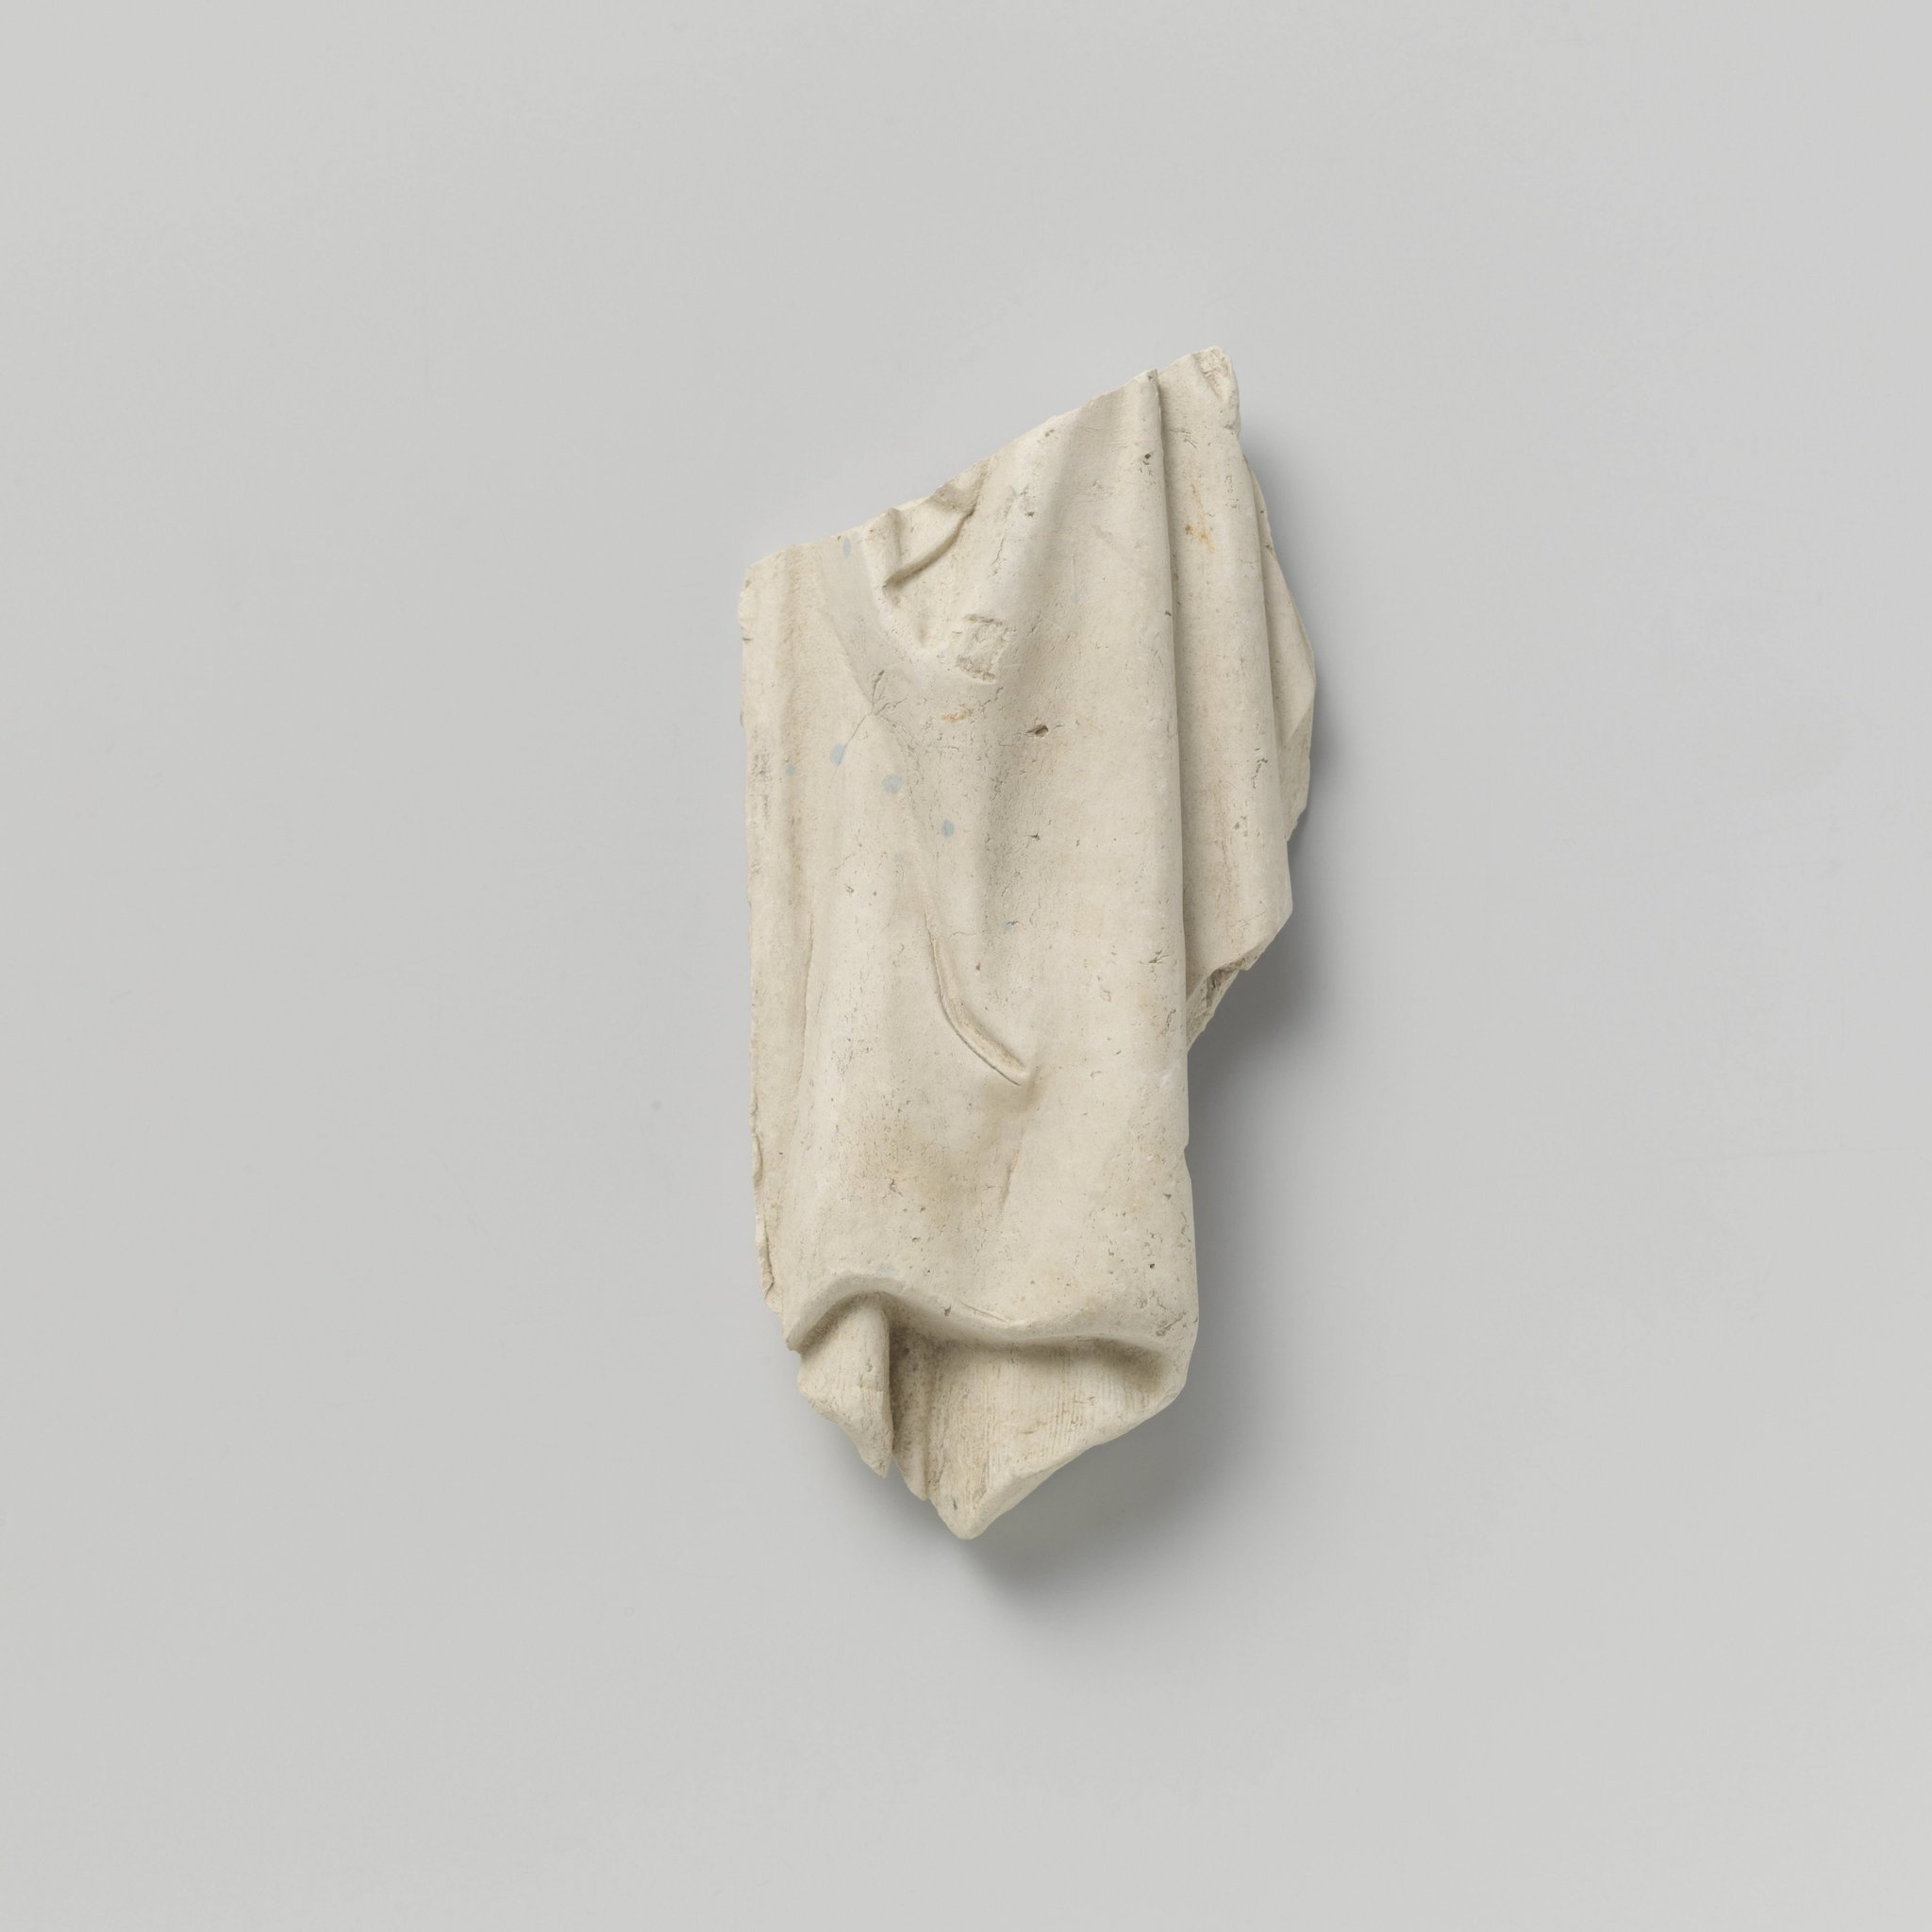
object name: sculpture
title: Figurine, Fragment of the Garment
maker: Anonymous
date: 1425-1550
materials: clay, terracotta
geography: northern netherlands